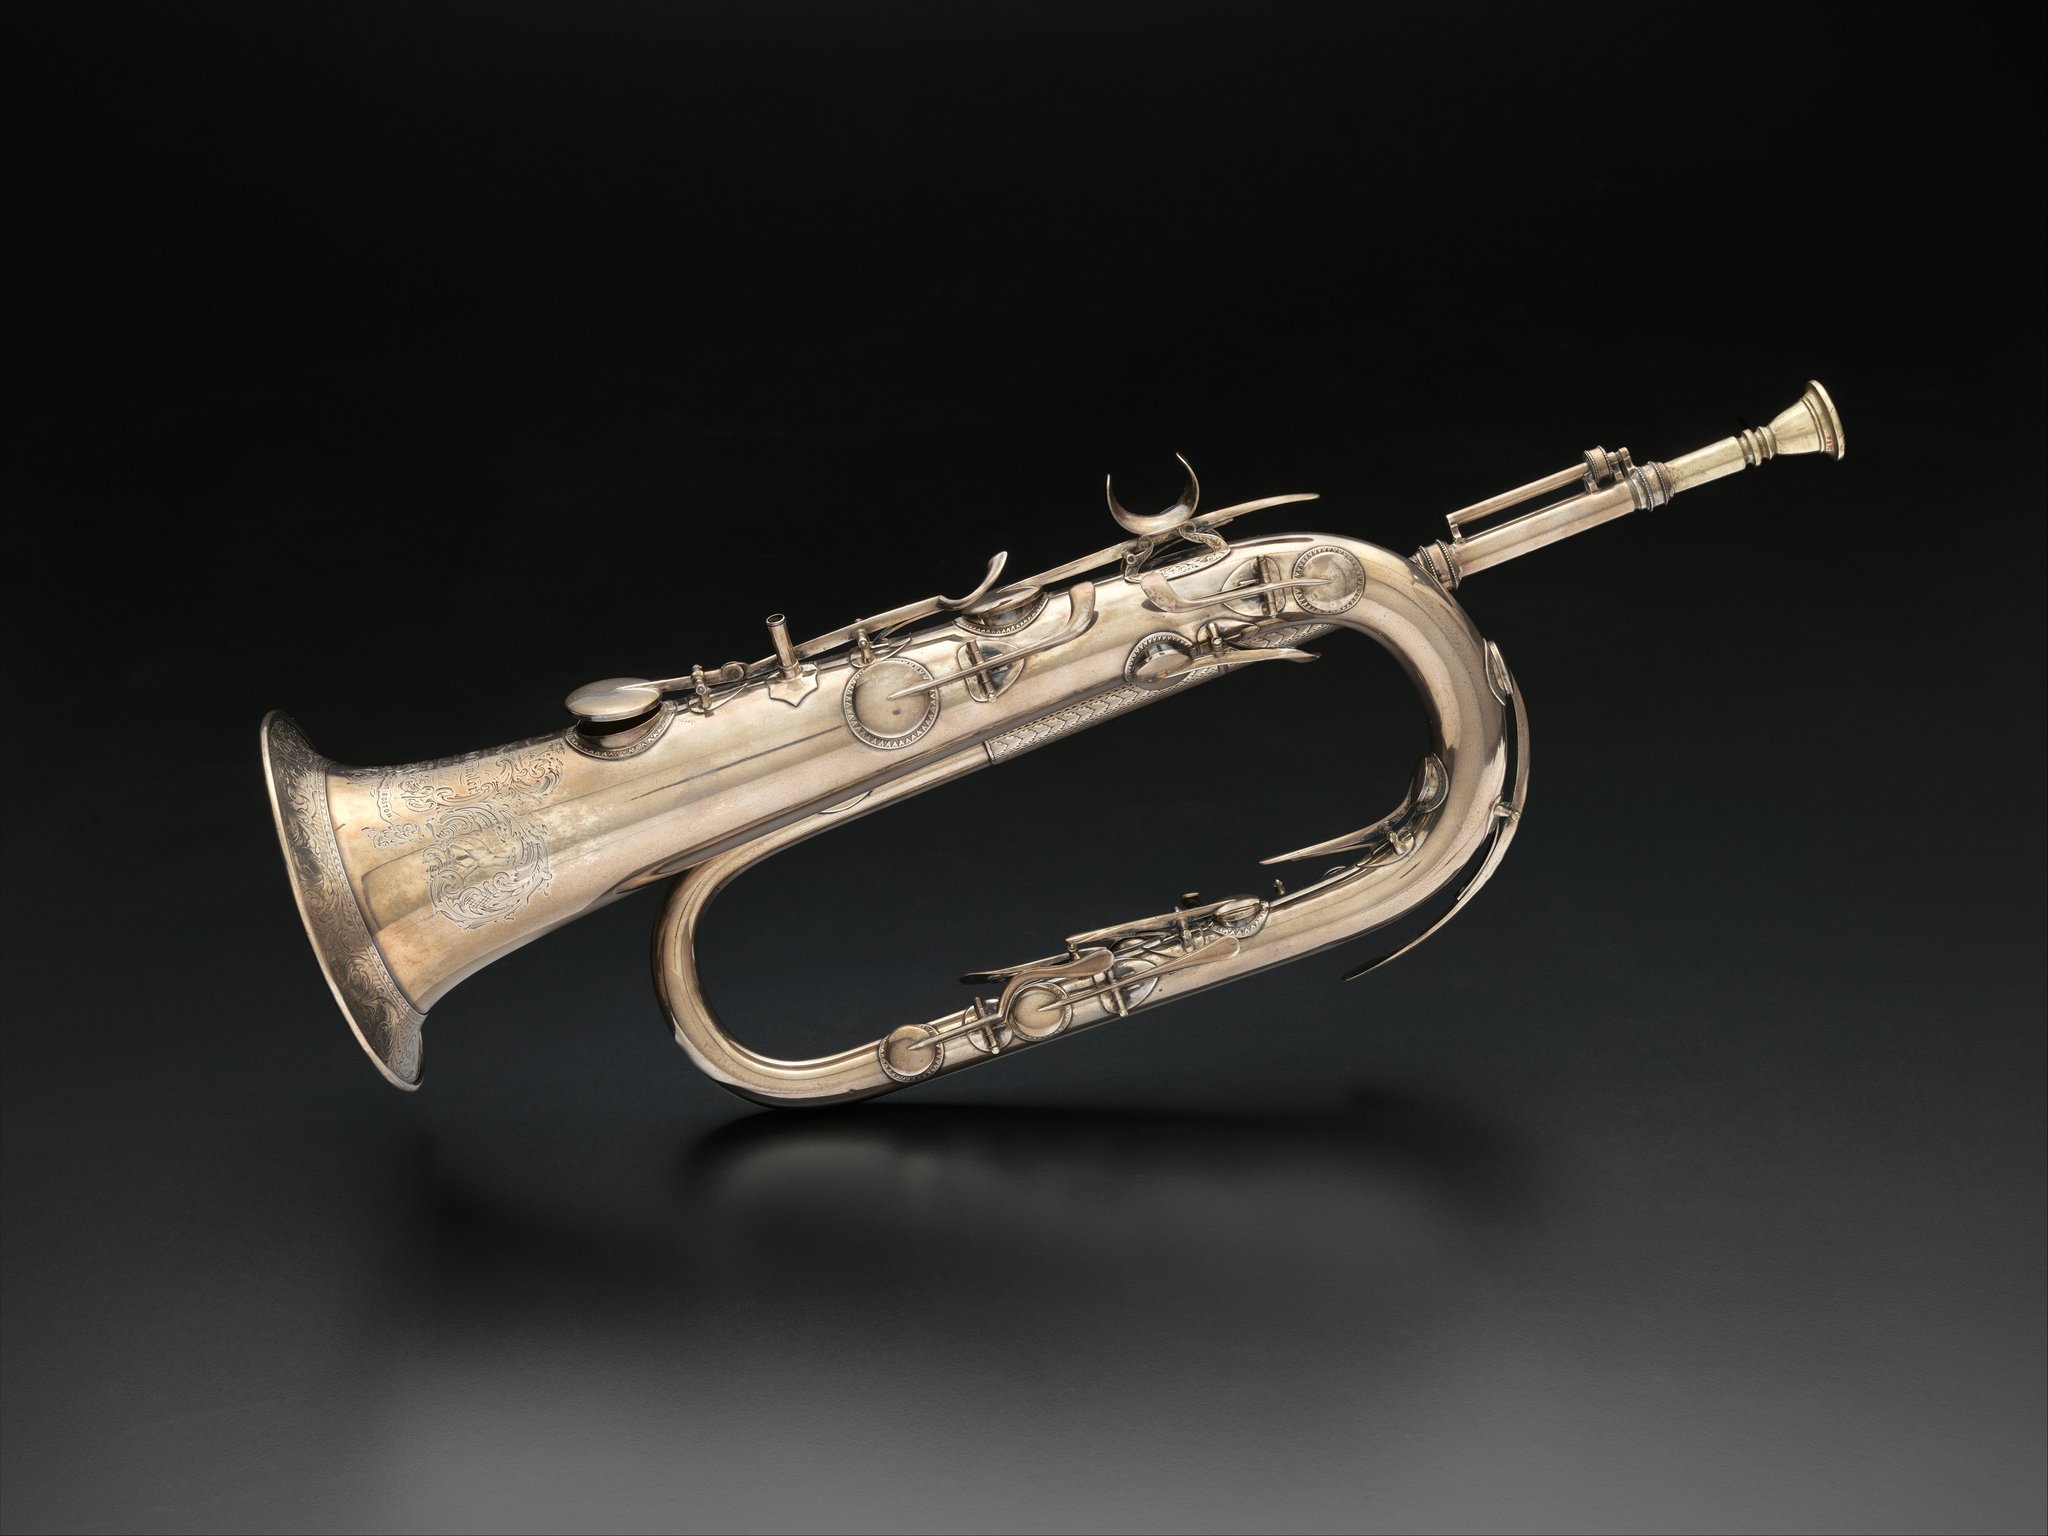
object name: keyed bugle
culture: american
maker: elbridge g. wright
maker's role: maker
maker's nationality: american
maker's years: 1839-1871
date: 1854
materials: silver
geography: united states